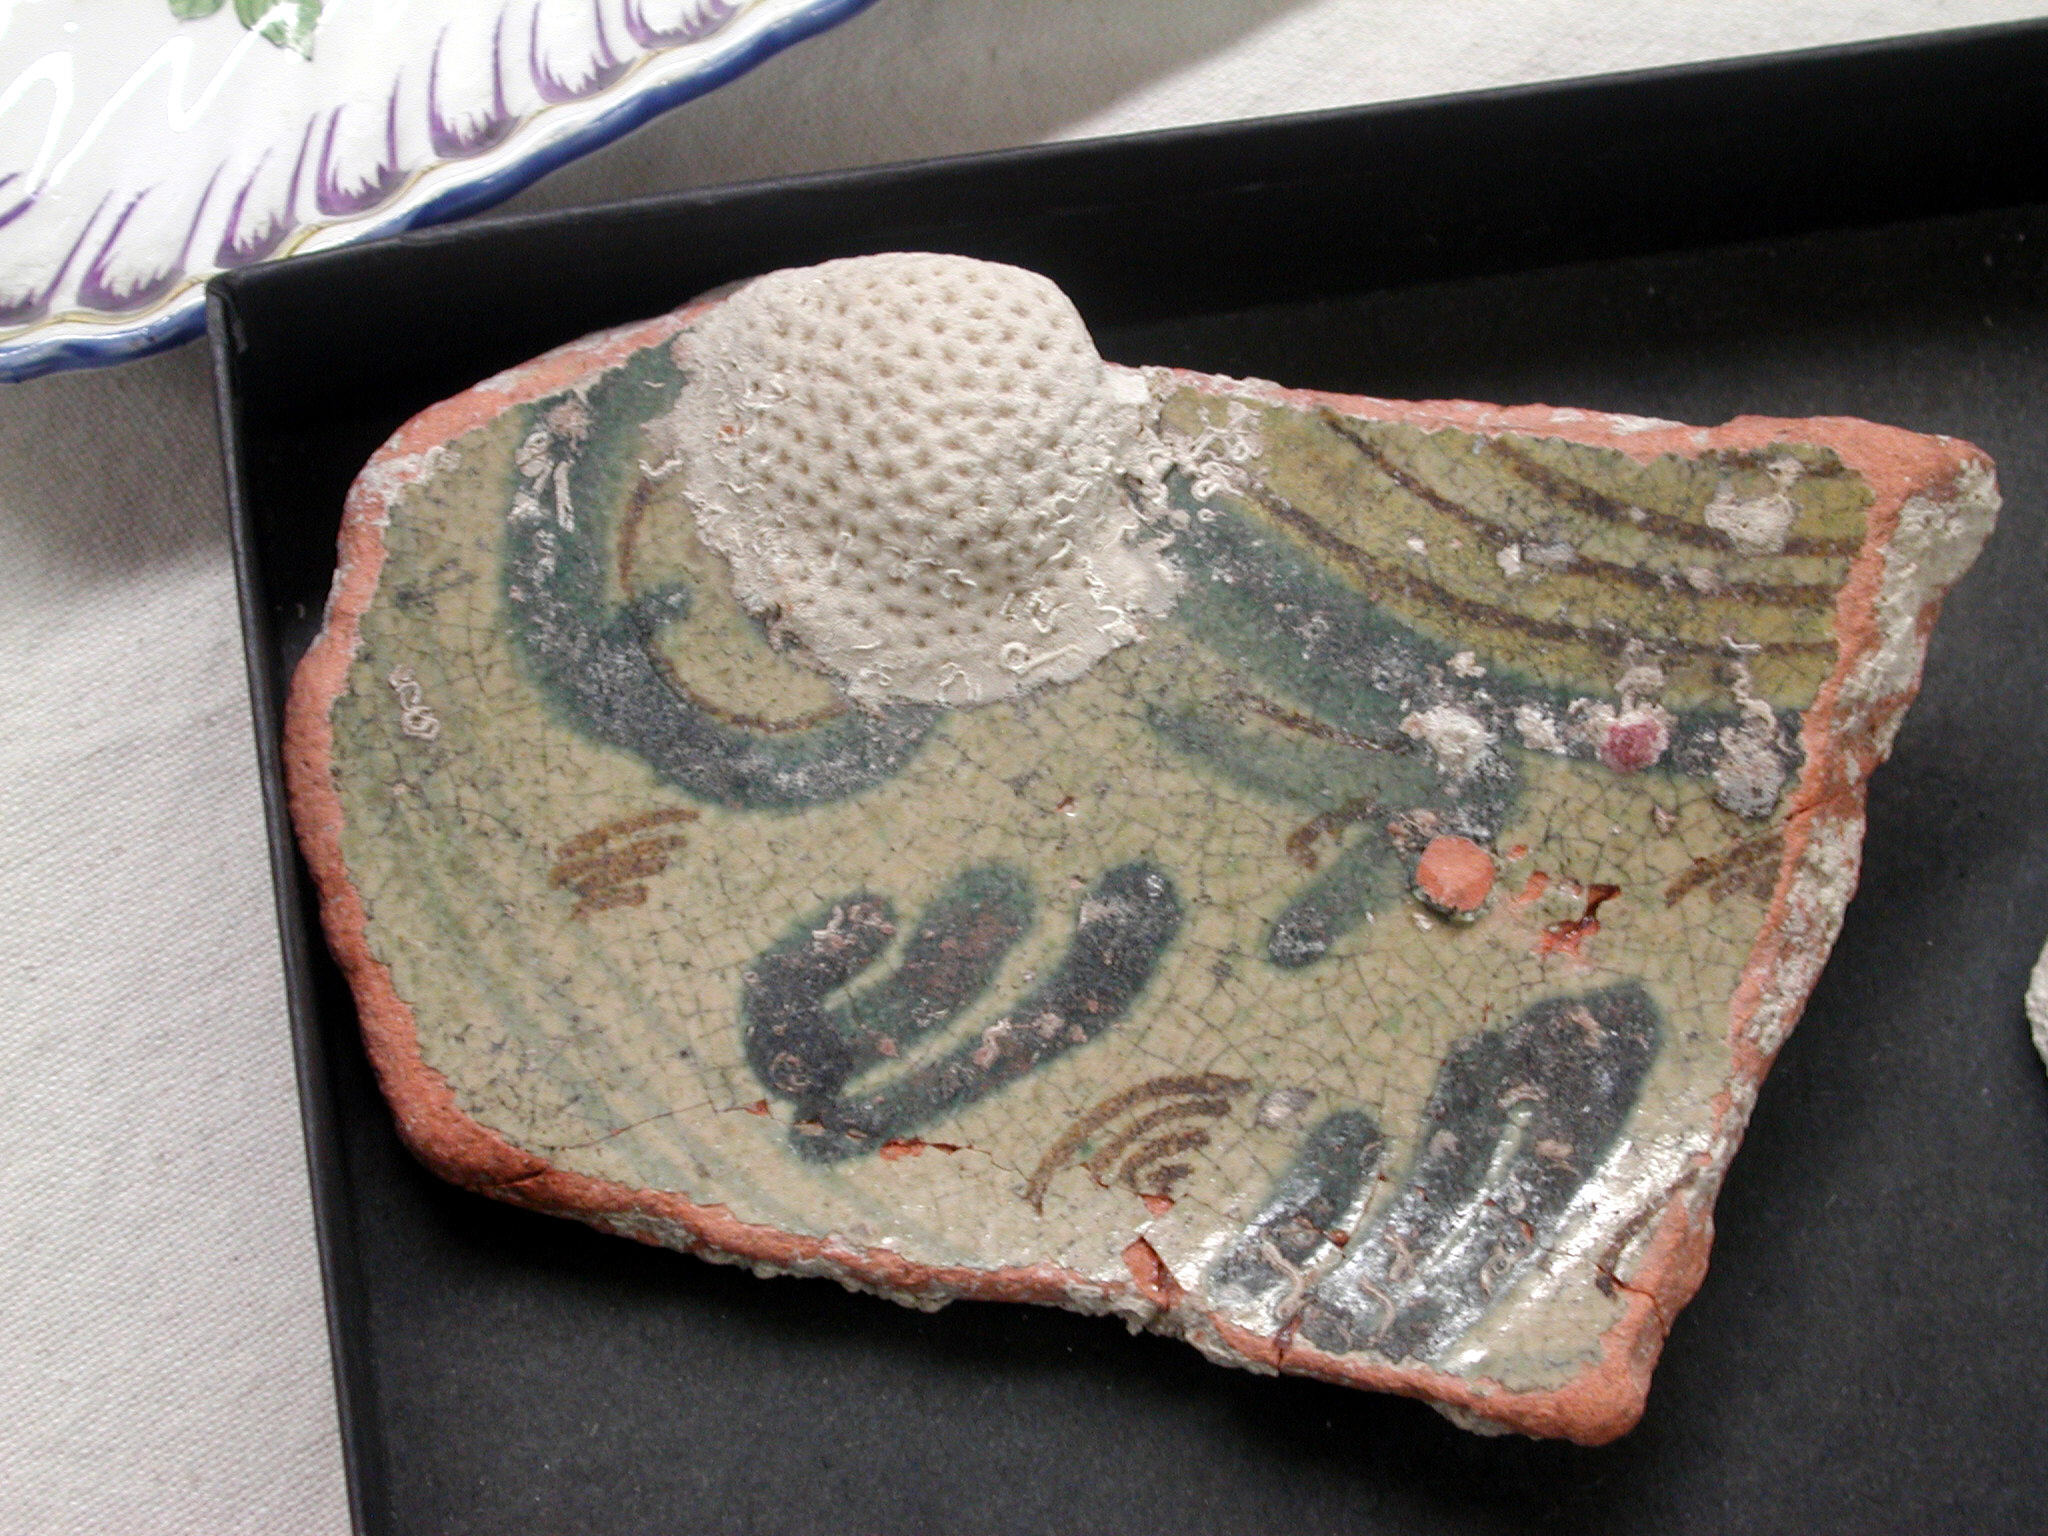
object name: fragment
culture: mexican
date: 1601-1650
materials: earthenware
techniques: glazing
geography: mexico